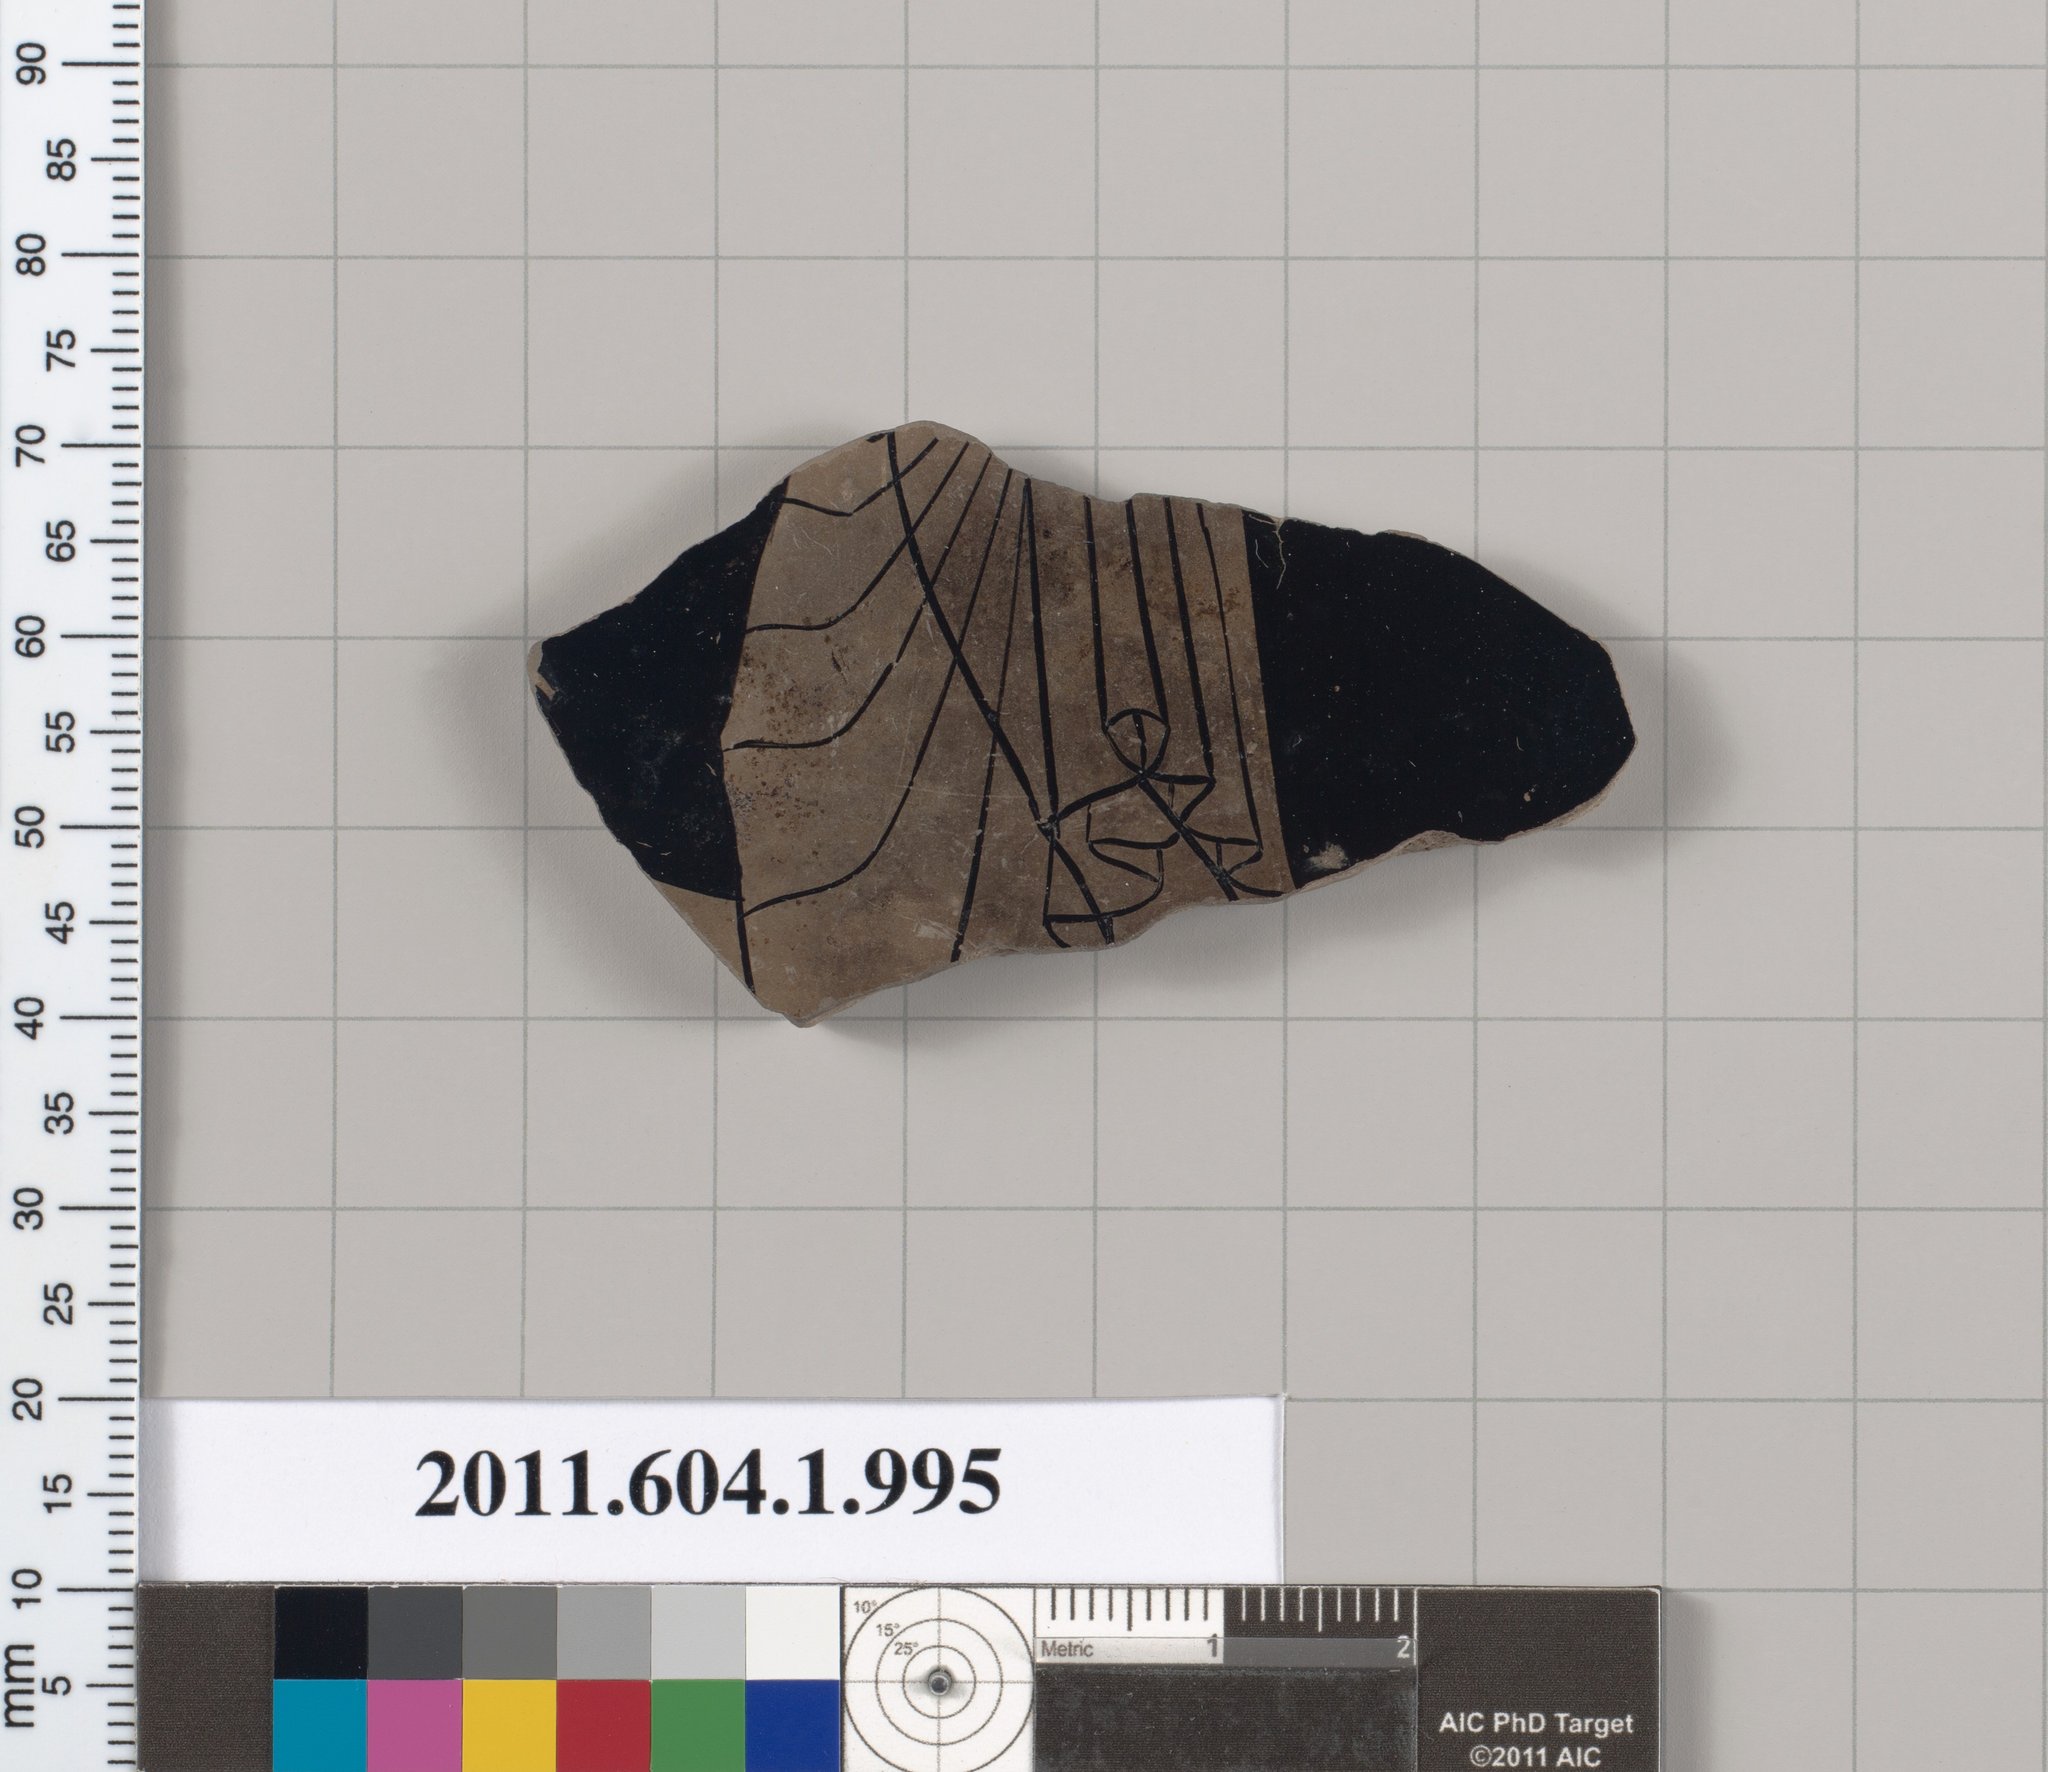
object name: kylix fragment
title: Terracotta fragment of a kylix (drinking cup)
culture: greek, attic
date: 475-451 BCE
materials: terracotta